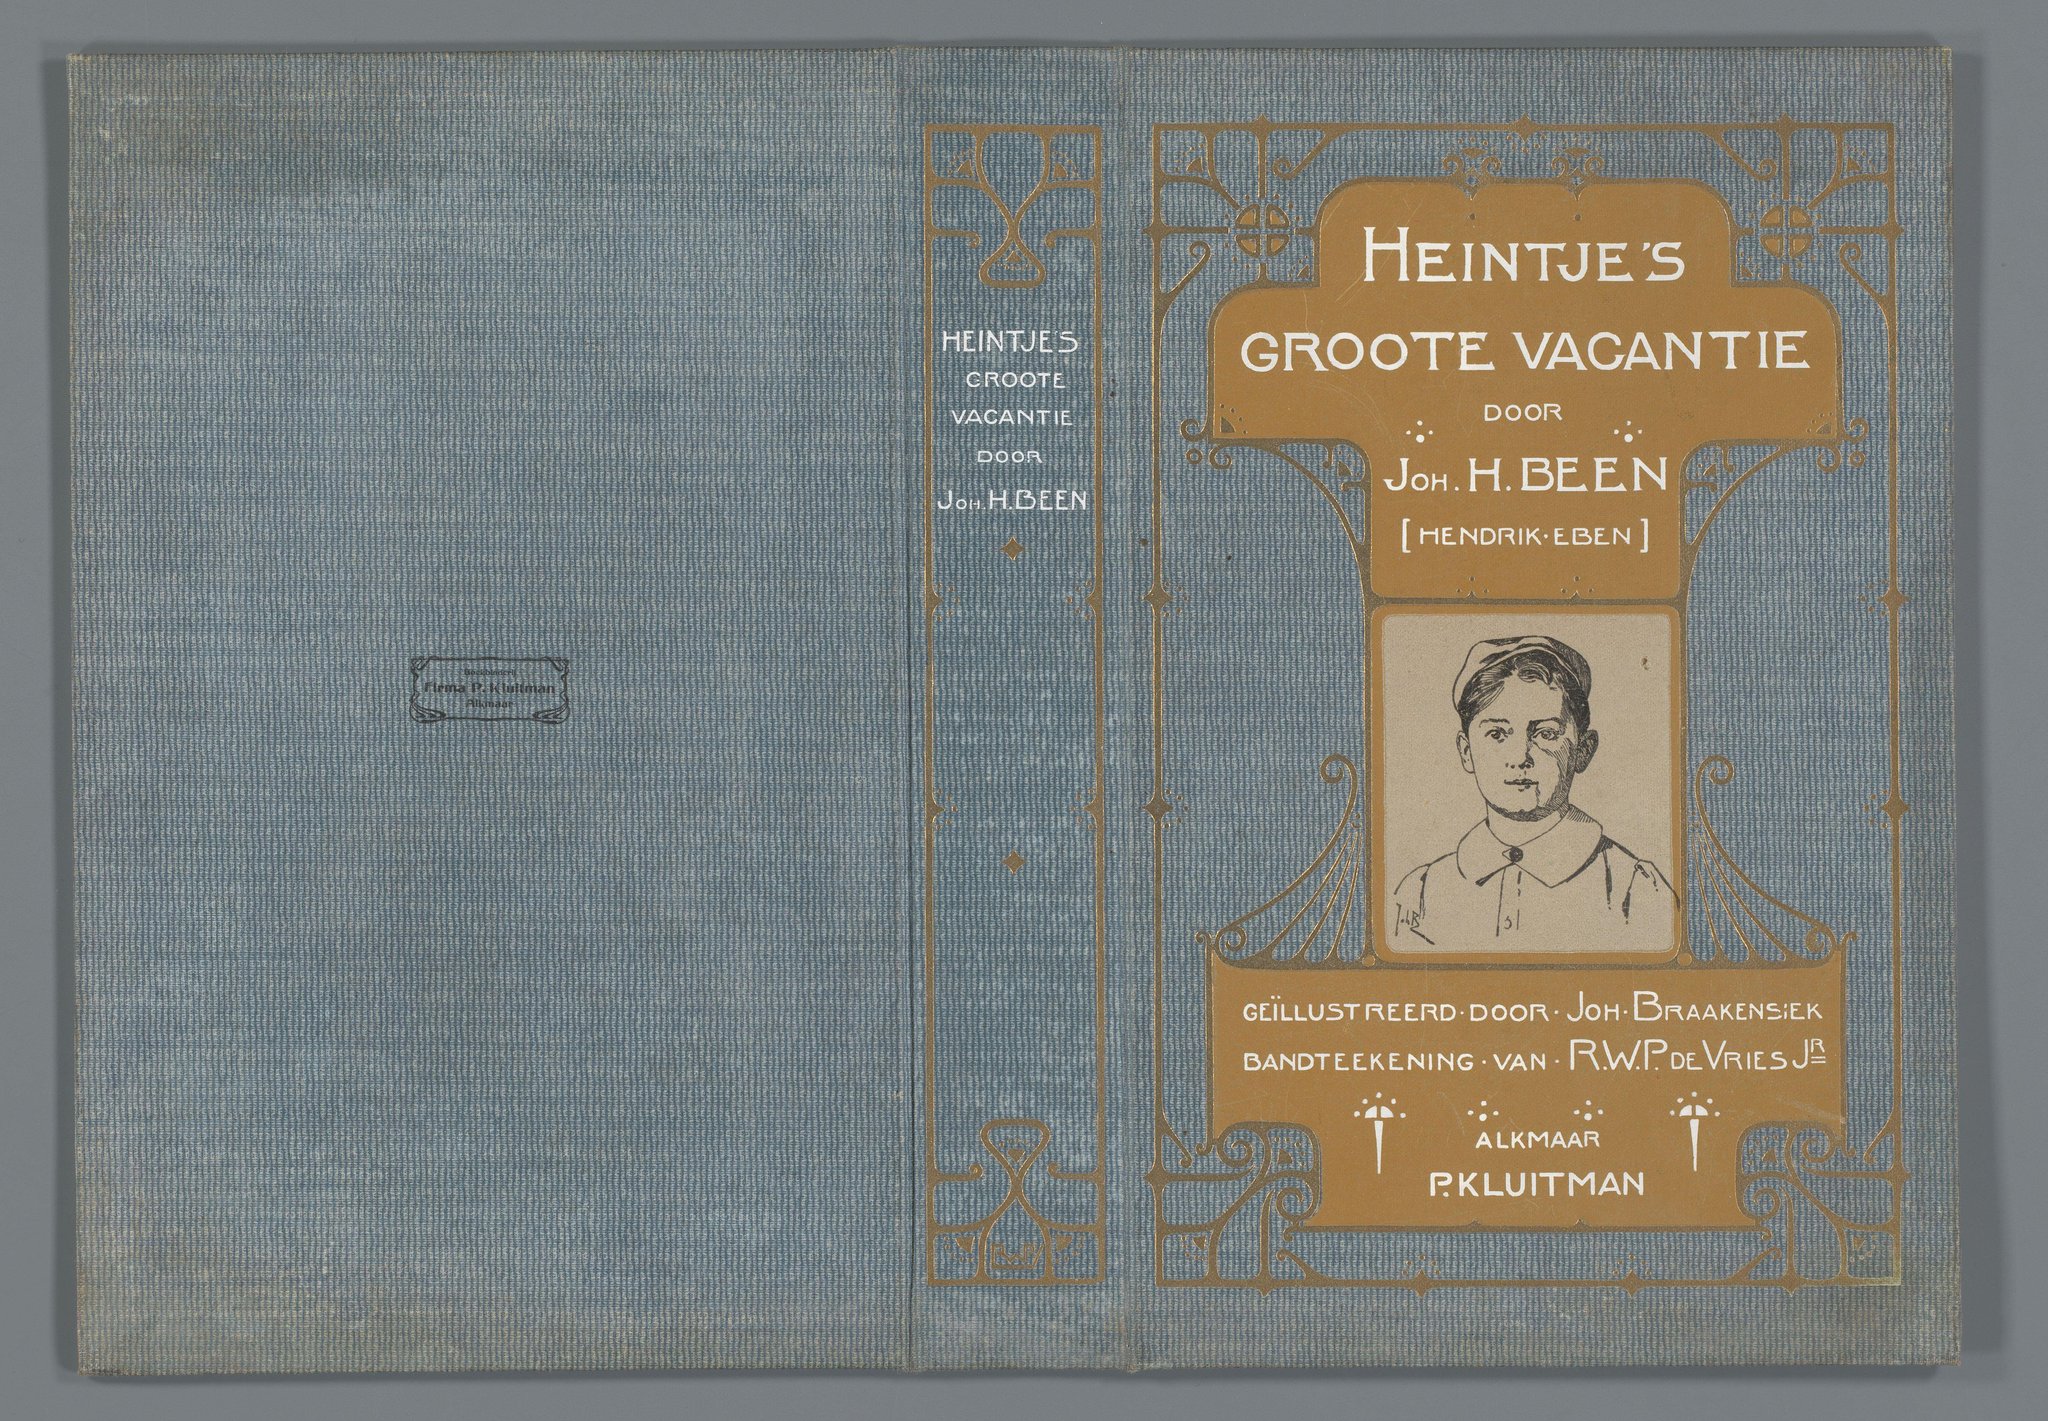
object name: binding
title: Boekband voor: Joh. H. Been, Heintje's groote vacantie, 1905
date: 1905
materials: cardboard, linen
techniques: printing, printing block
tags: boy (child between toddler and youth)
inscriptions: collector's mark: ‘R:MVS.’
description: Boekband voor: Been, Joh. H. Heintje's groote vacantie. Alkmaar: P. Kluitman, 1905.